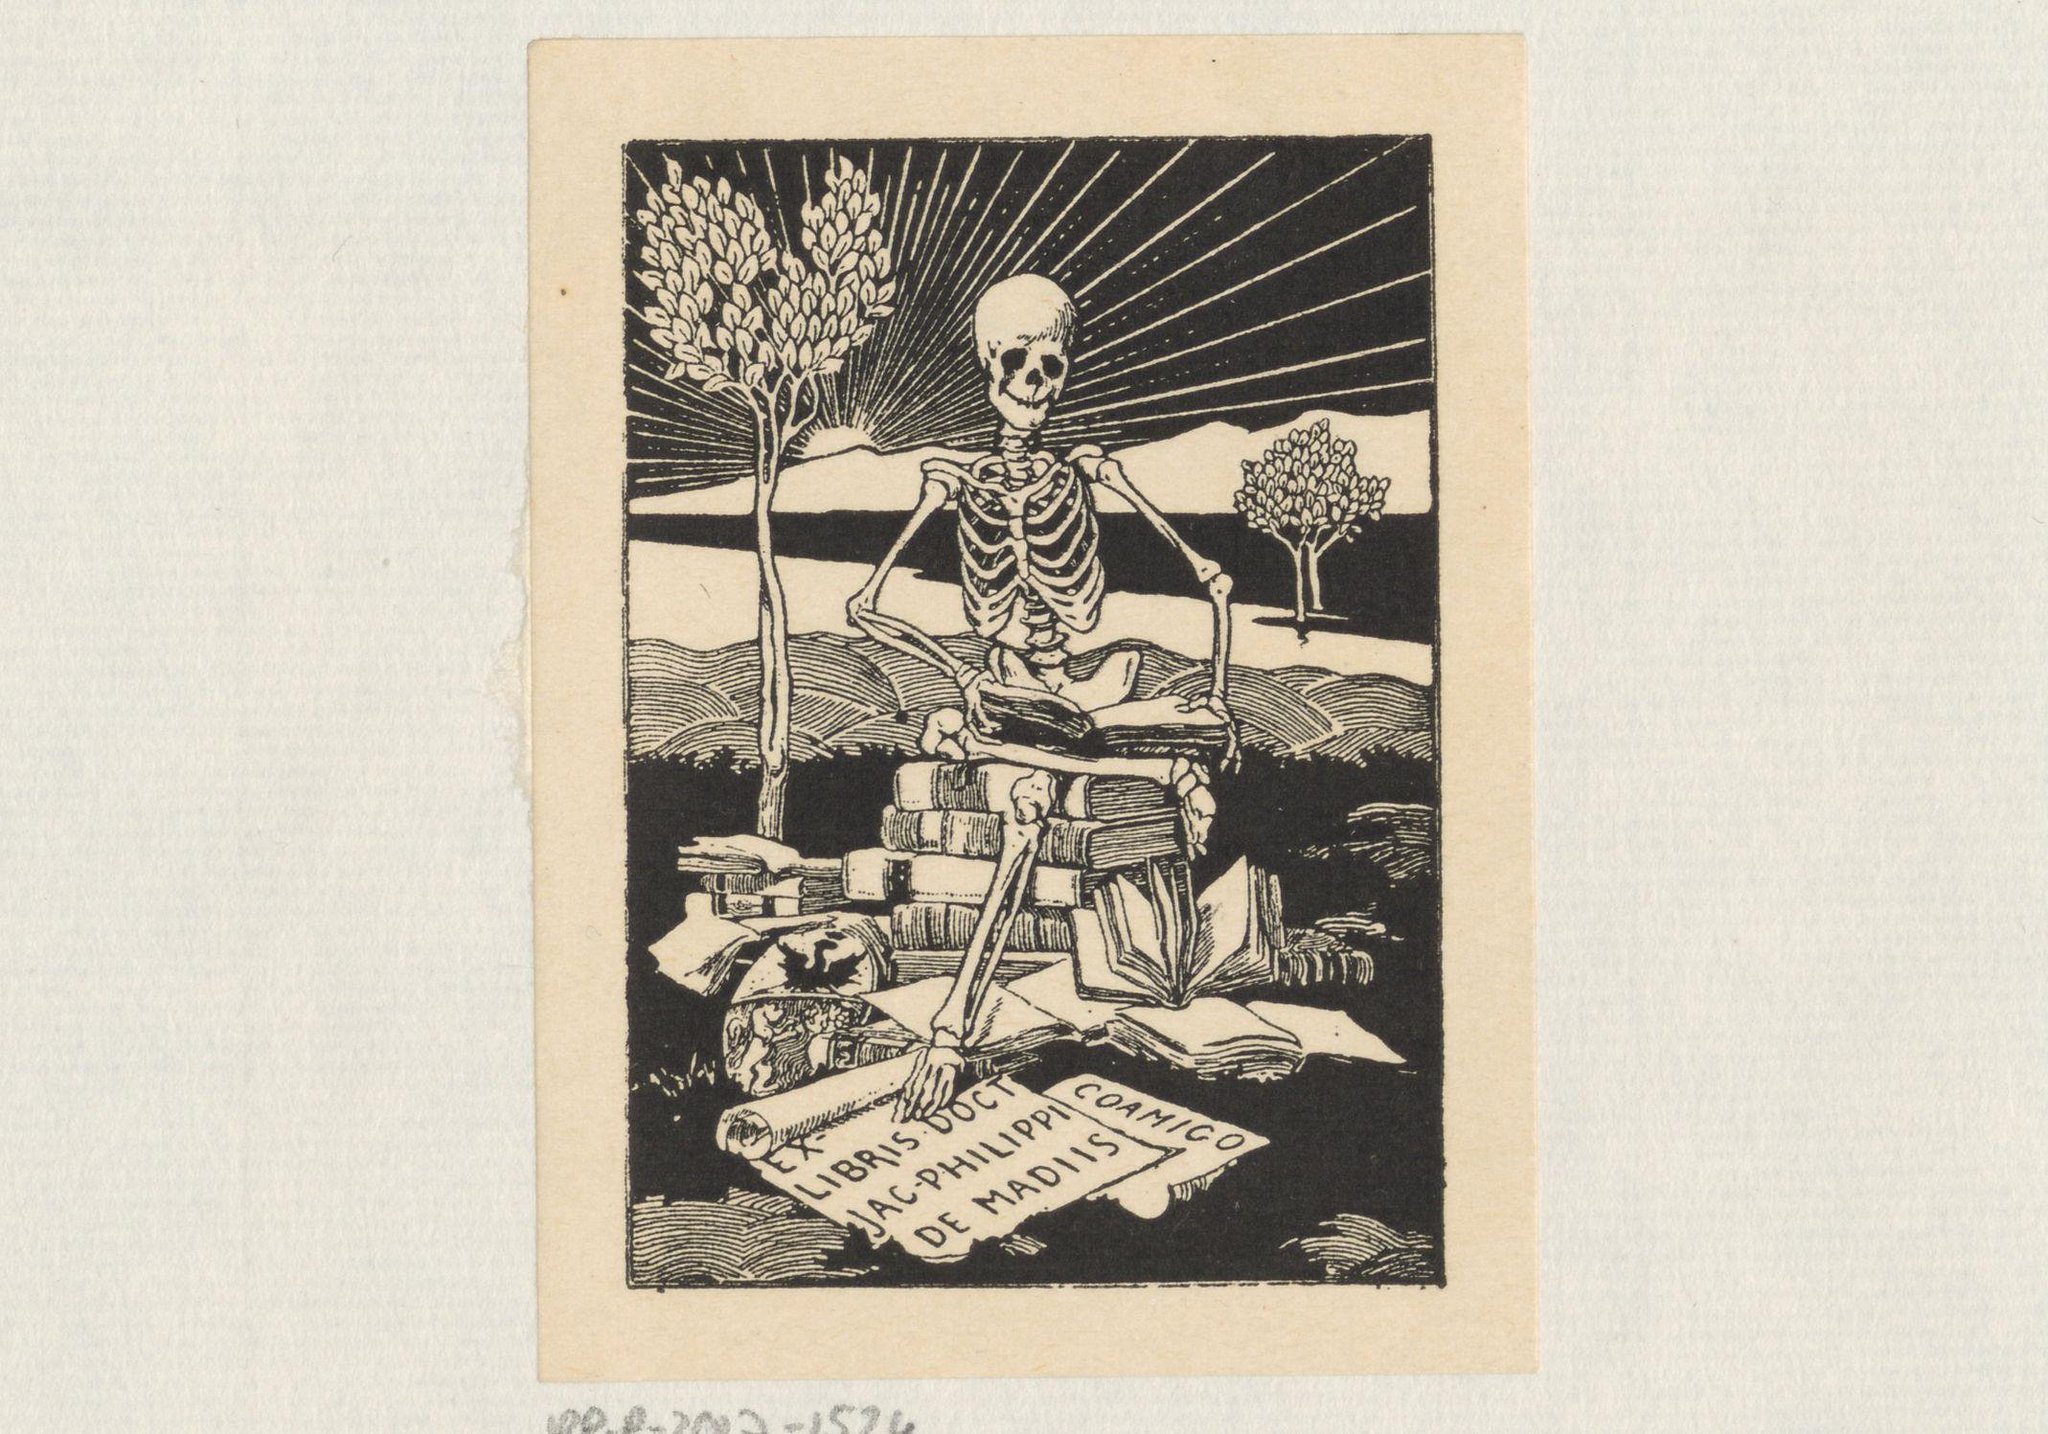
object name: bookplate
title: Ex libris van Jacopo Filippo de Madi [?]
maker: Anonymous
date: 1899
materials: paper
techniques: printing block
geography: italy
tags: landscapes, book, (human) skeleton, sunset